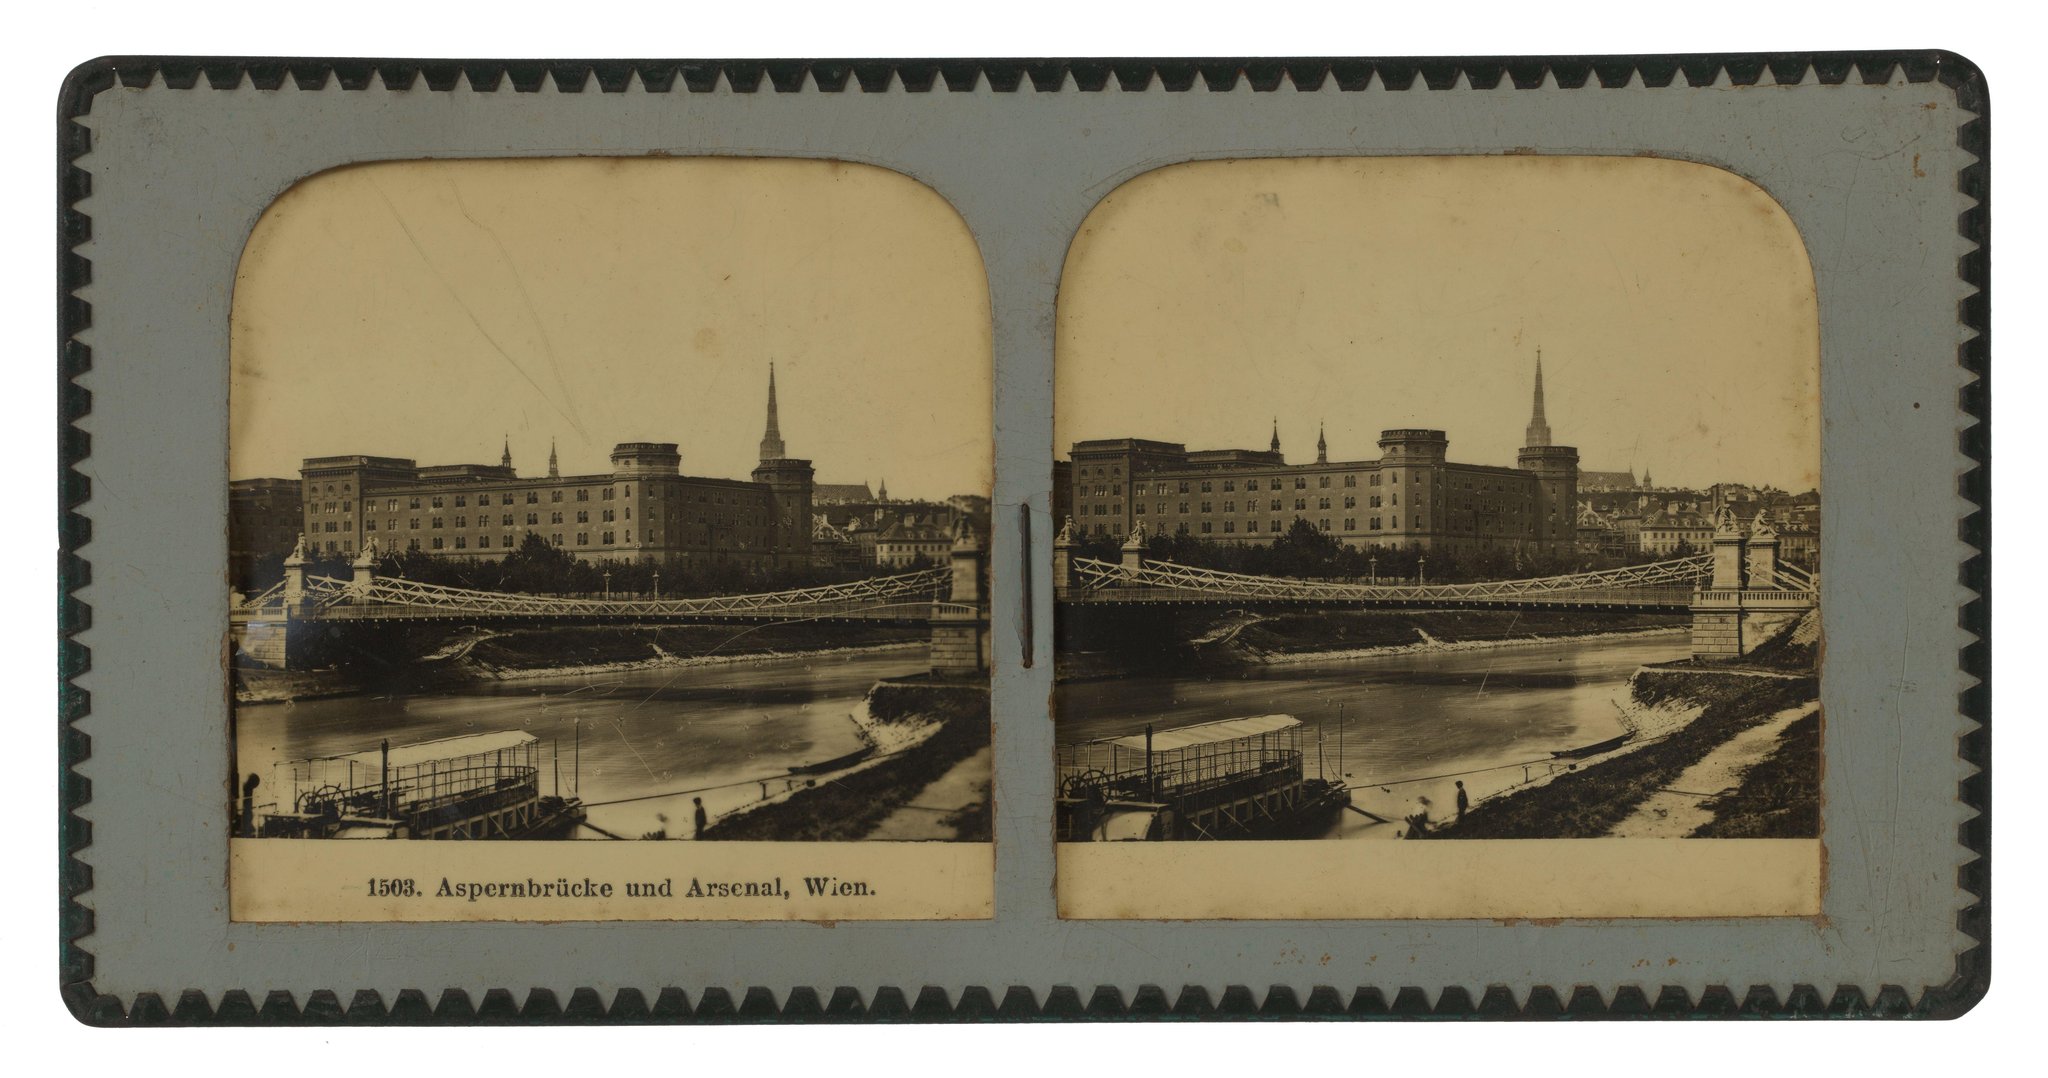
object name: stereograph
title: Gezicht op het Arsenaal in Wenen met de Aspernbrücke op de voorgrond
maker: Anonymous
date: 1900-1940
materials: cardboard, film, metal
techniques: gelatin silver print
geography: vienna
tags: bridge in city across river, canal, etc., ammunition store, arsenal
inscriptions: number: ‘1503.’